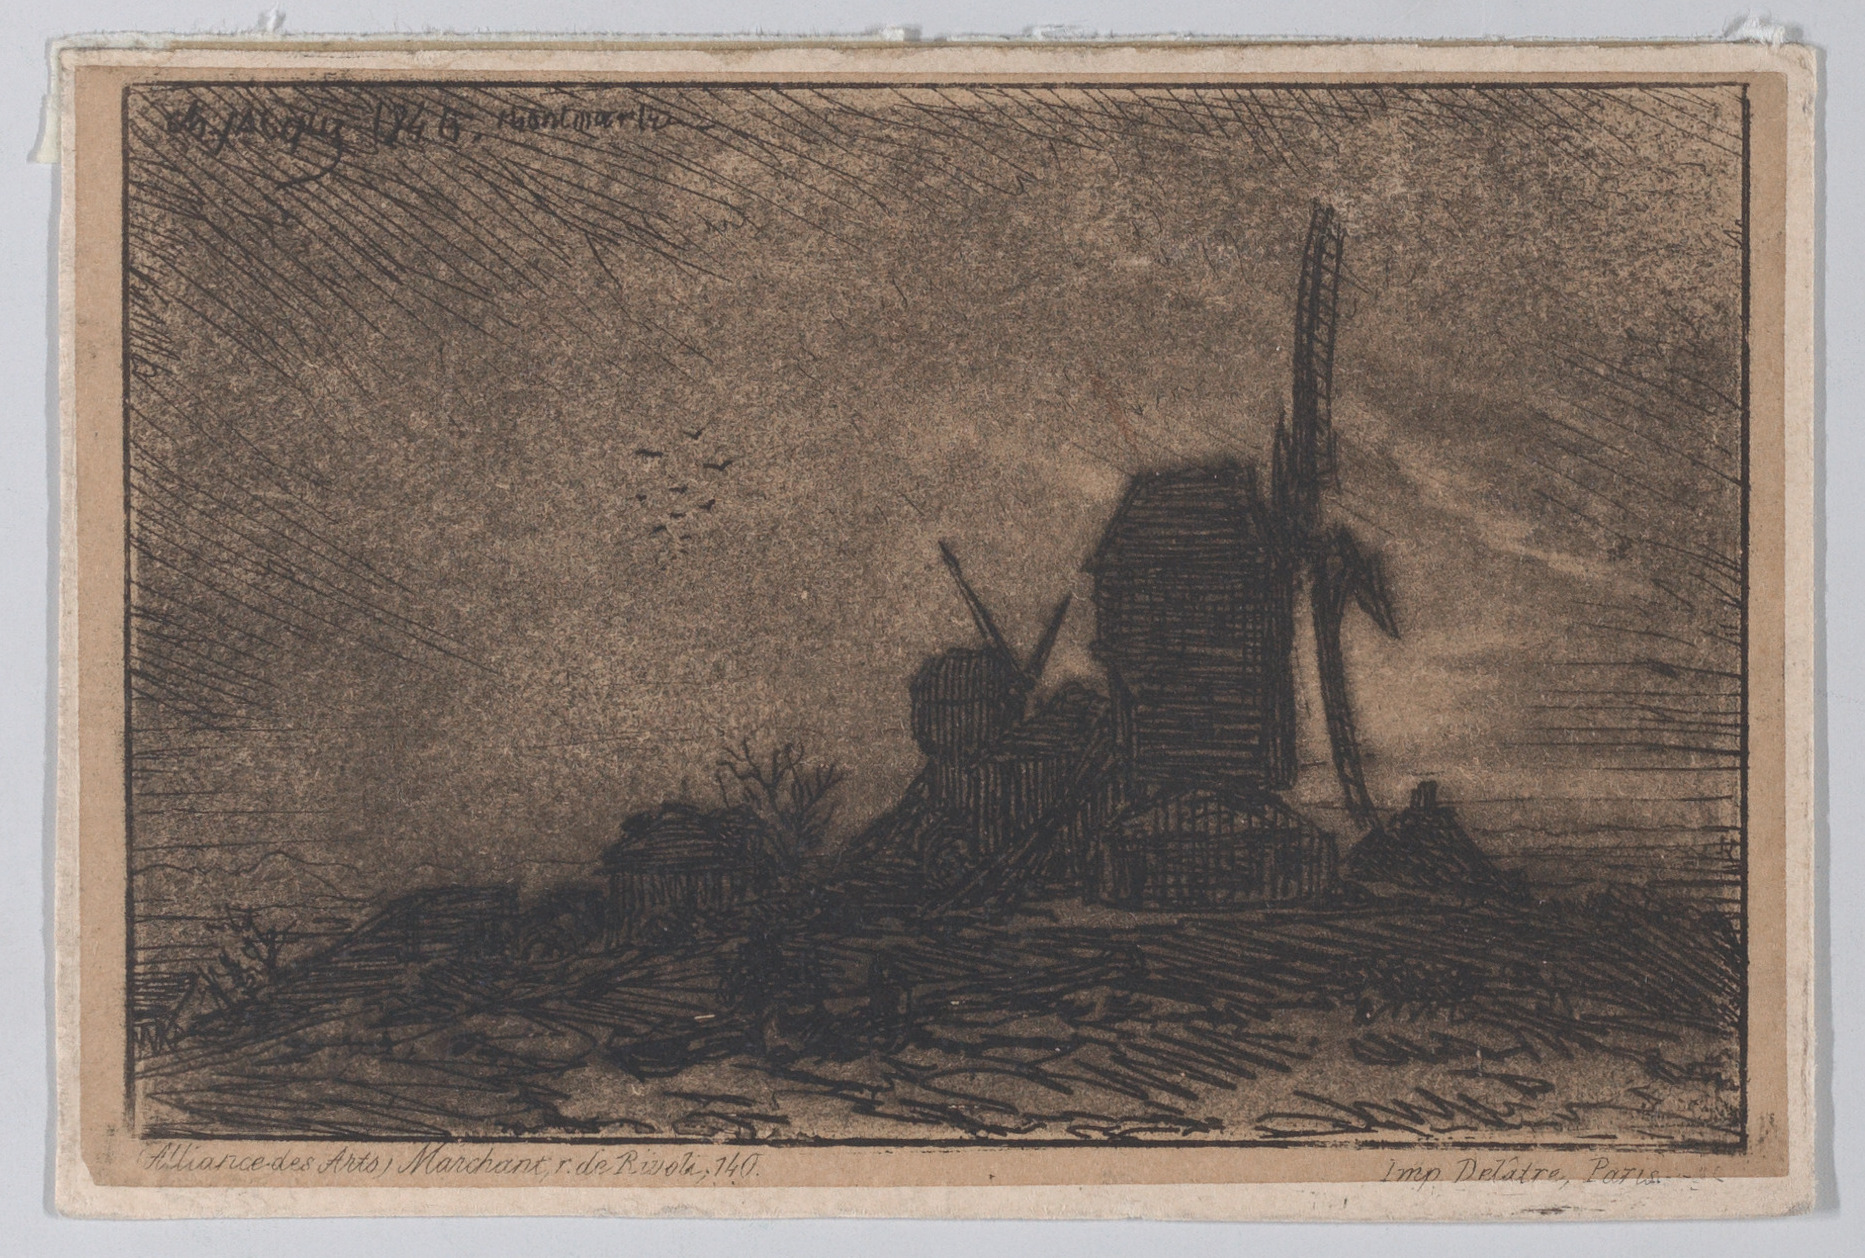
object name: print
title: Two Windmills in Montmartre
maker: charles émile jacque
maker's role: artist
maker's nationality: french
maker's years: 1813-1894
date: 1846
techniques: etching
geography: paris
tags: windmills